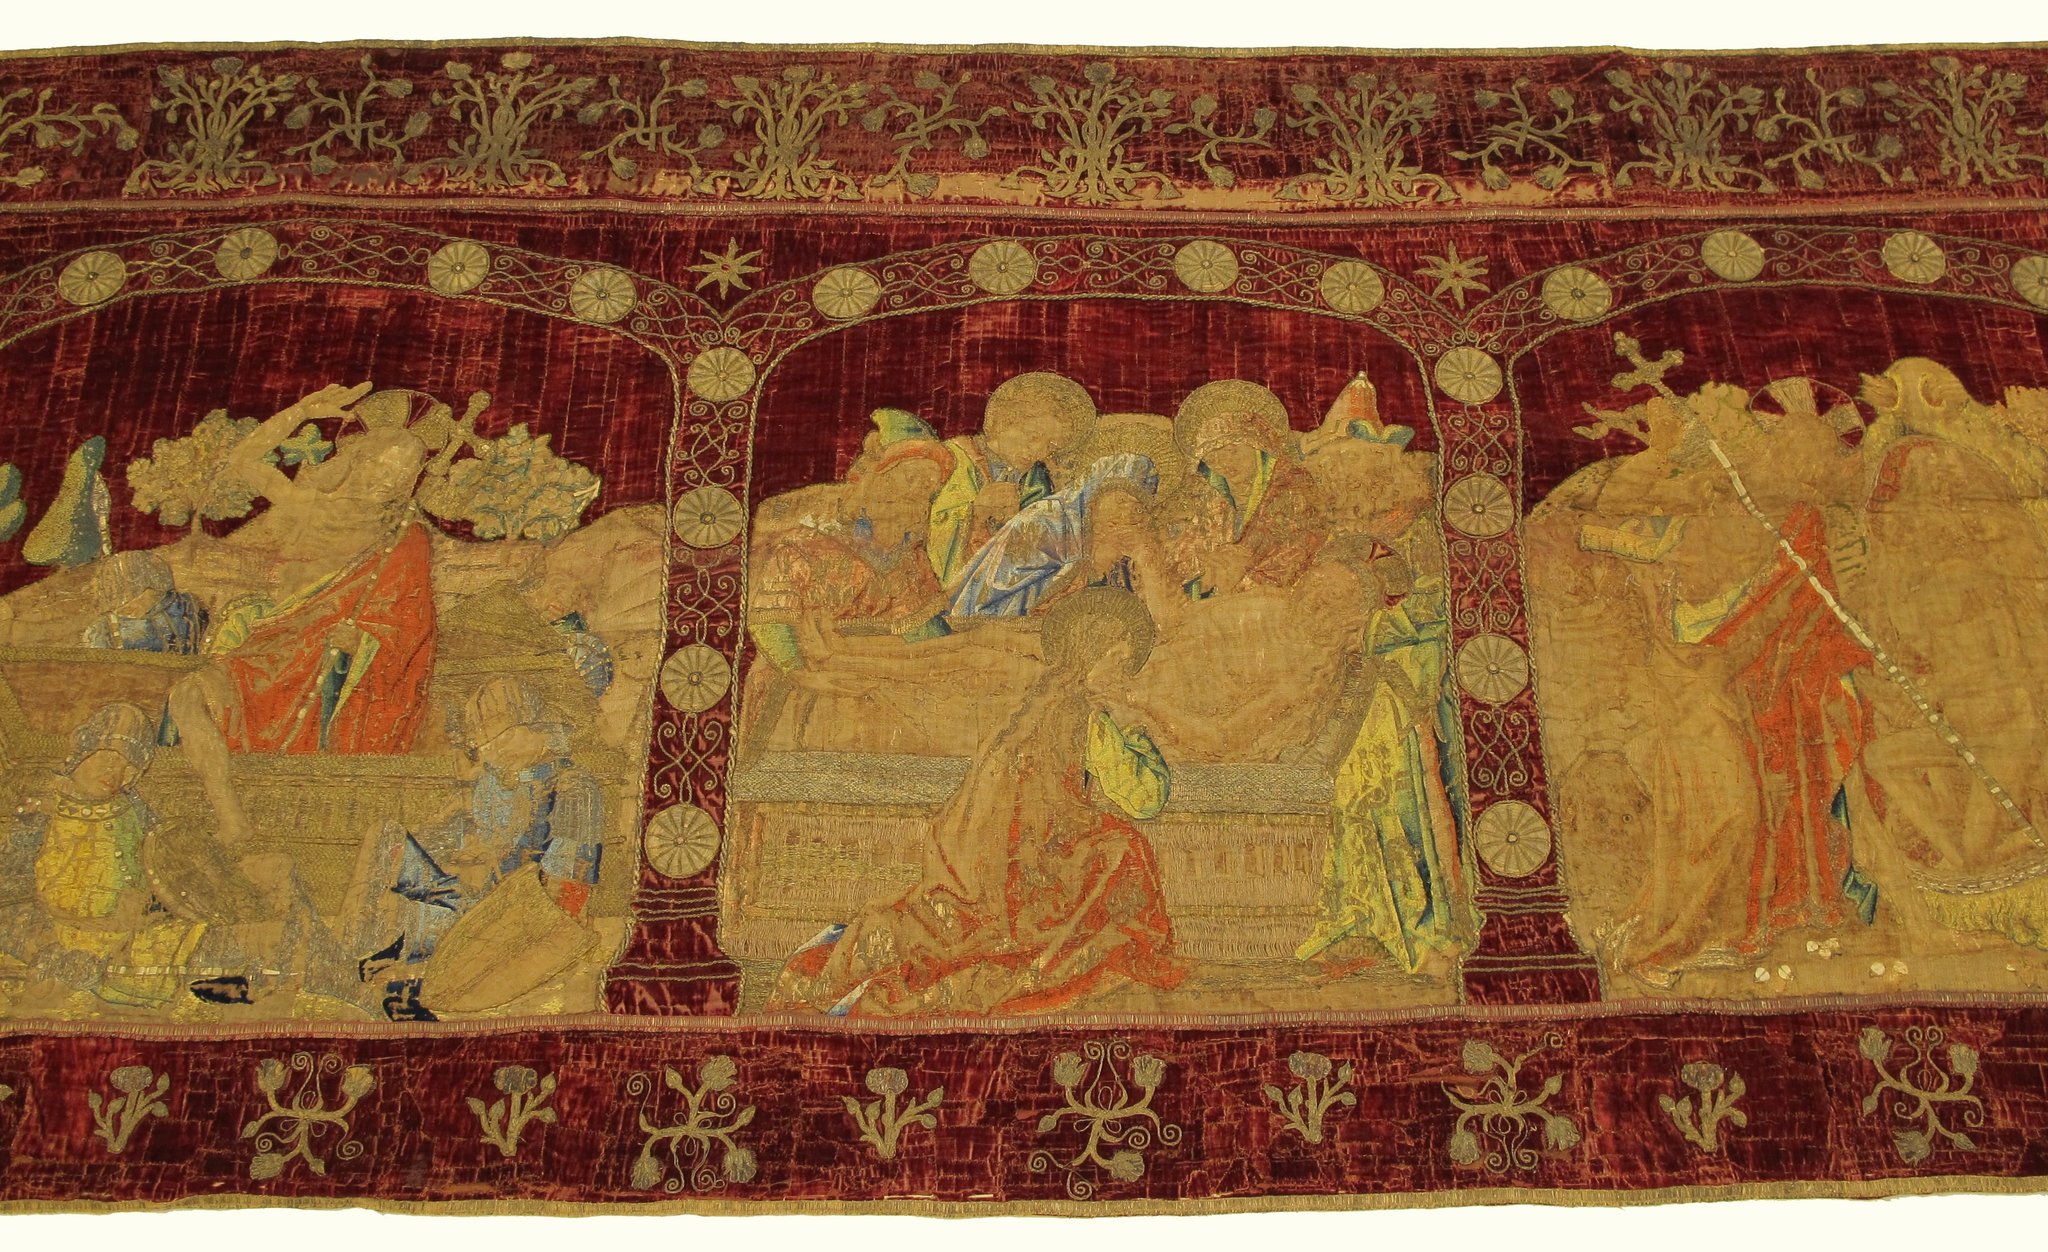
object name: altar frontal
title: Textile, Altar Frontal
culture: french or italian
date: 1500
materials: metal thread, silk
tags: christ,entombment,resurrection